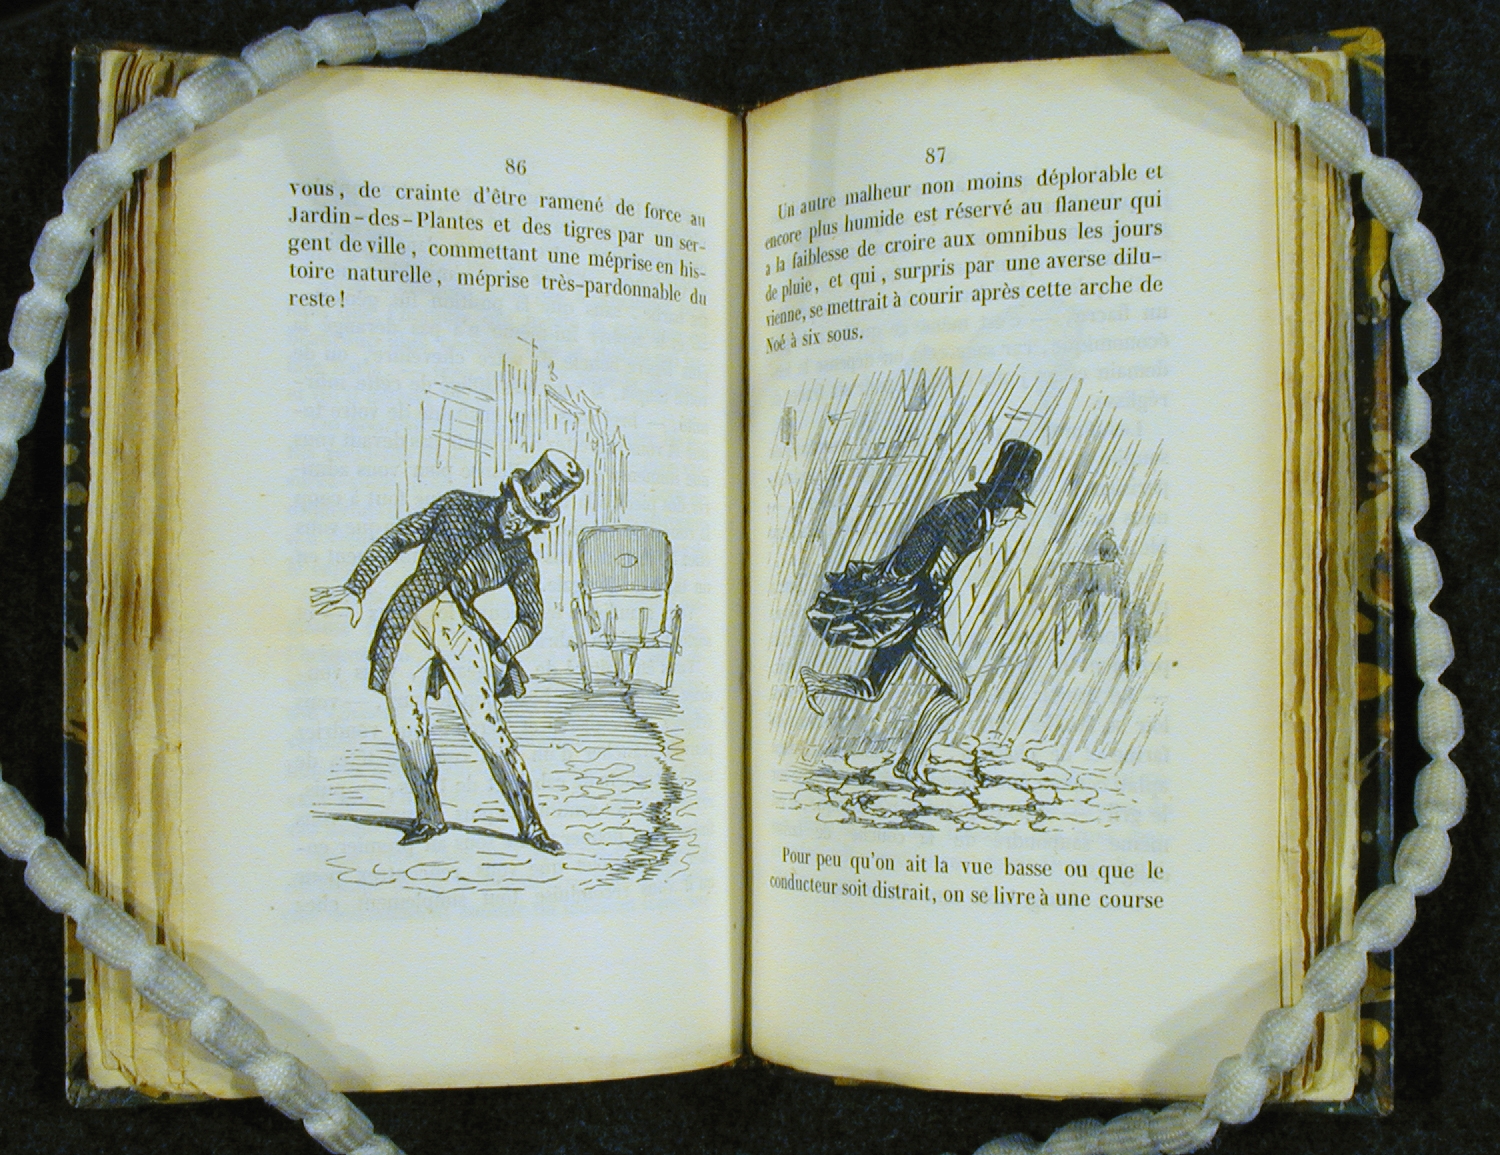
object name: book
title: Physiologie du Flaneur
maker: louis huart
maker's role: author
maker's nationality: french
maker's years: 1813-1865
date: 1841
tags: men